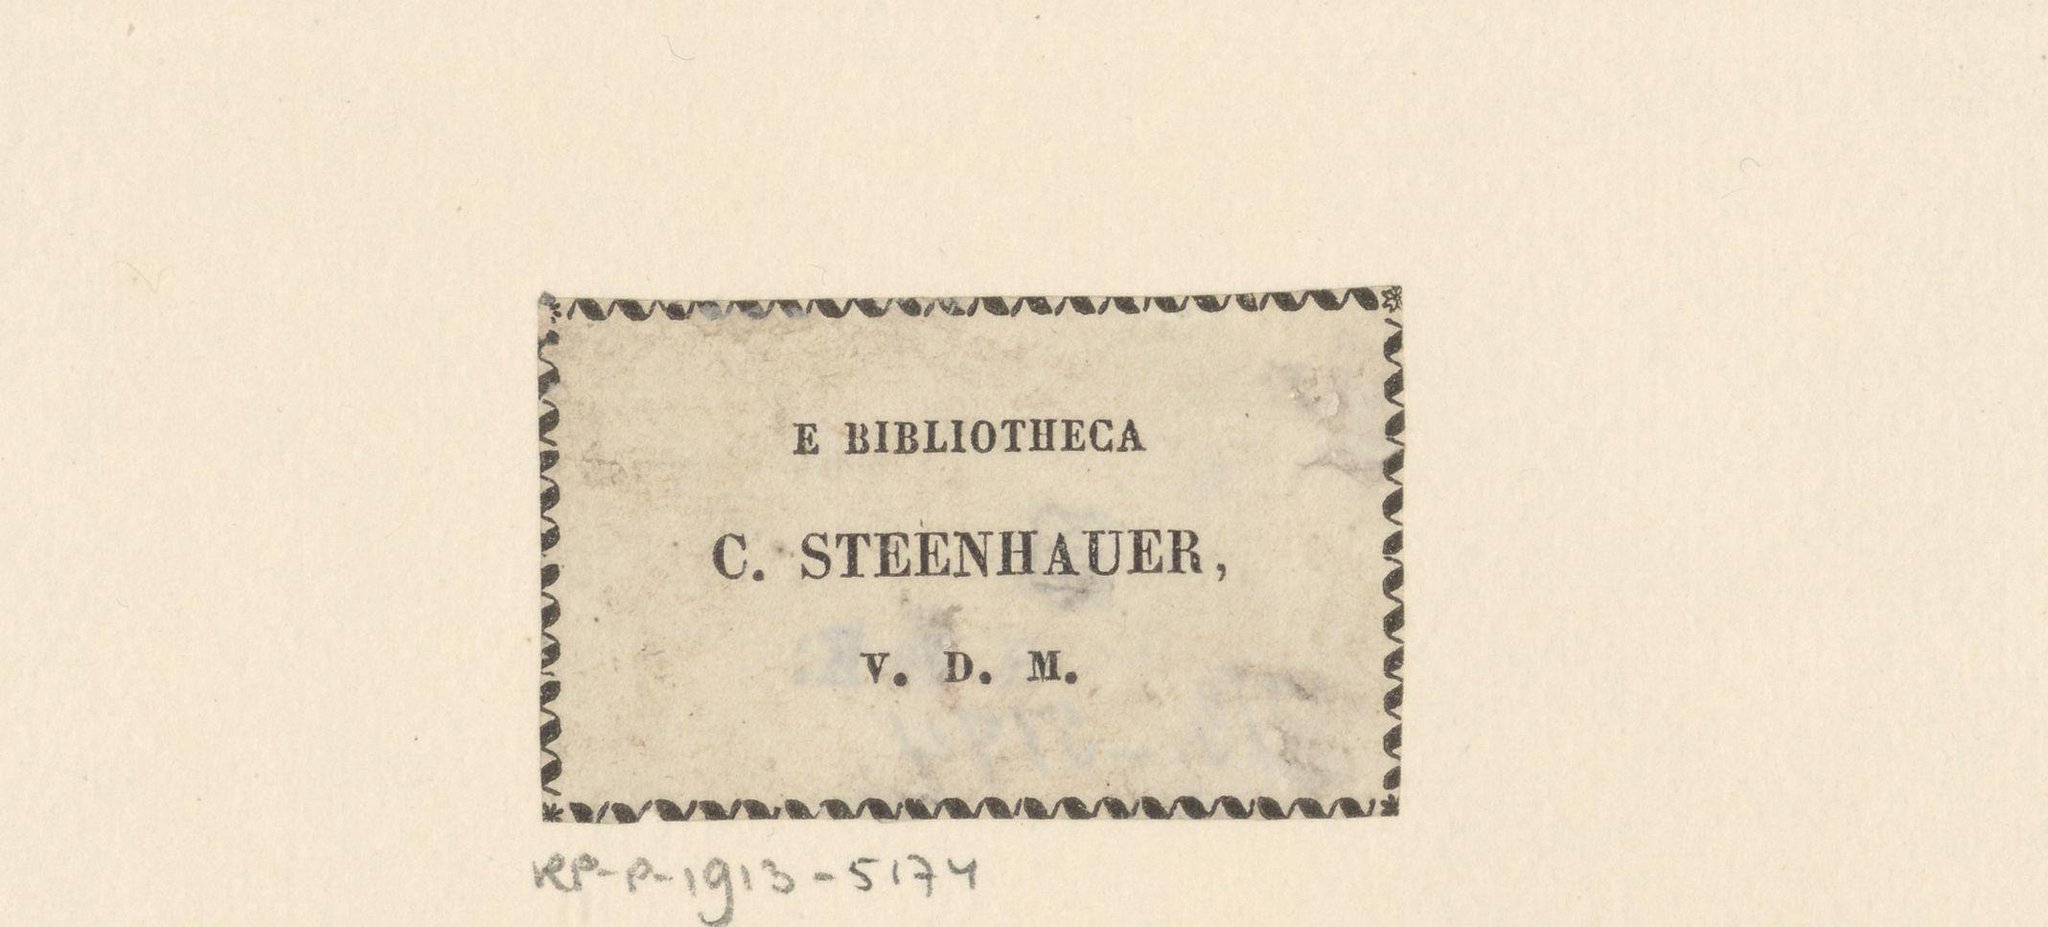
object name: bookplate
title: Ex libris van C. Steenhauer V.D.M.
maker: Anonymous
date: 1800-1913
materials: paper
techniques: printing block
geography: netherlands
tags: predikant, carel steenhauer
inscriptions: collector's mark: Lugt 2760, collector's mark: Lugt 2233